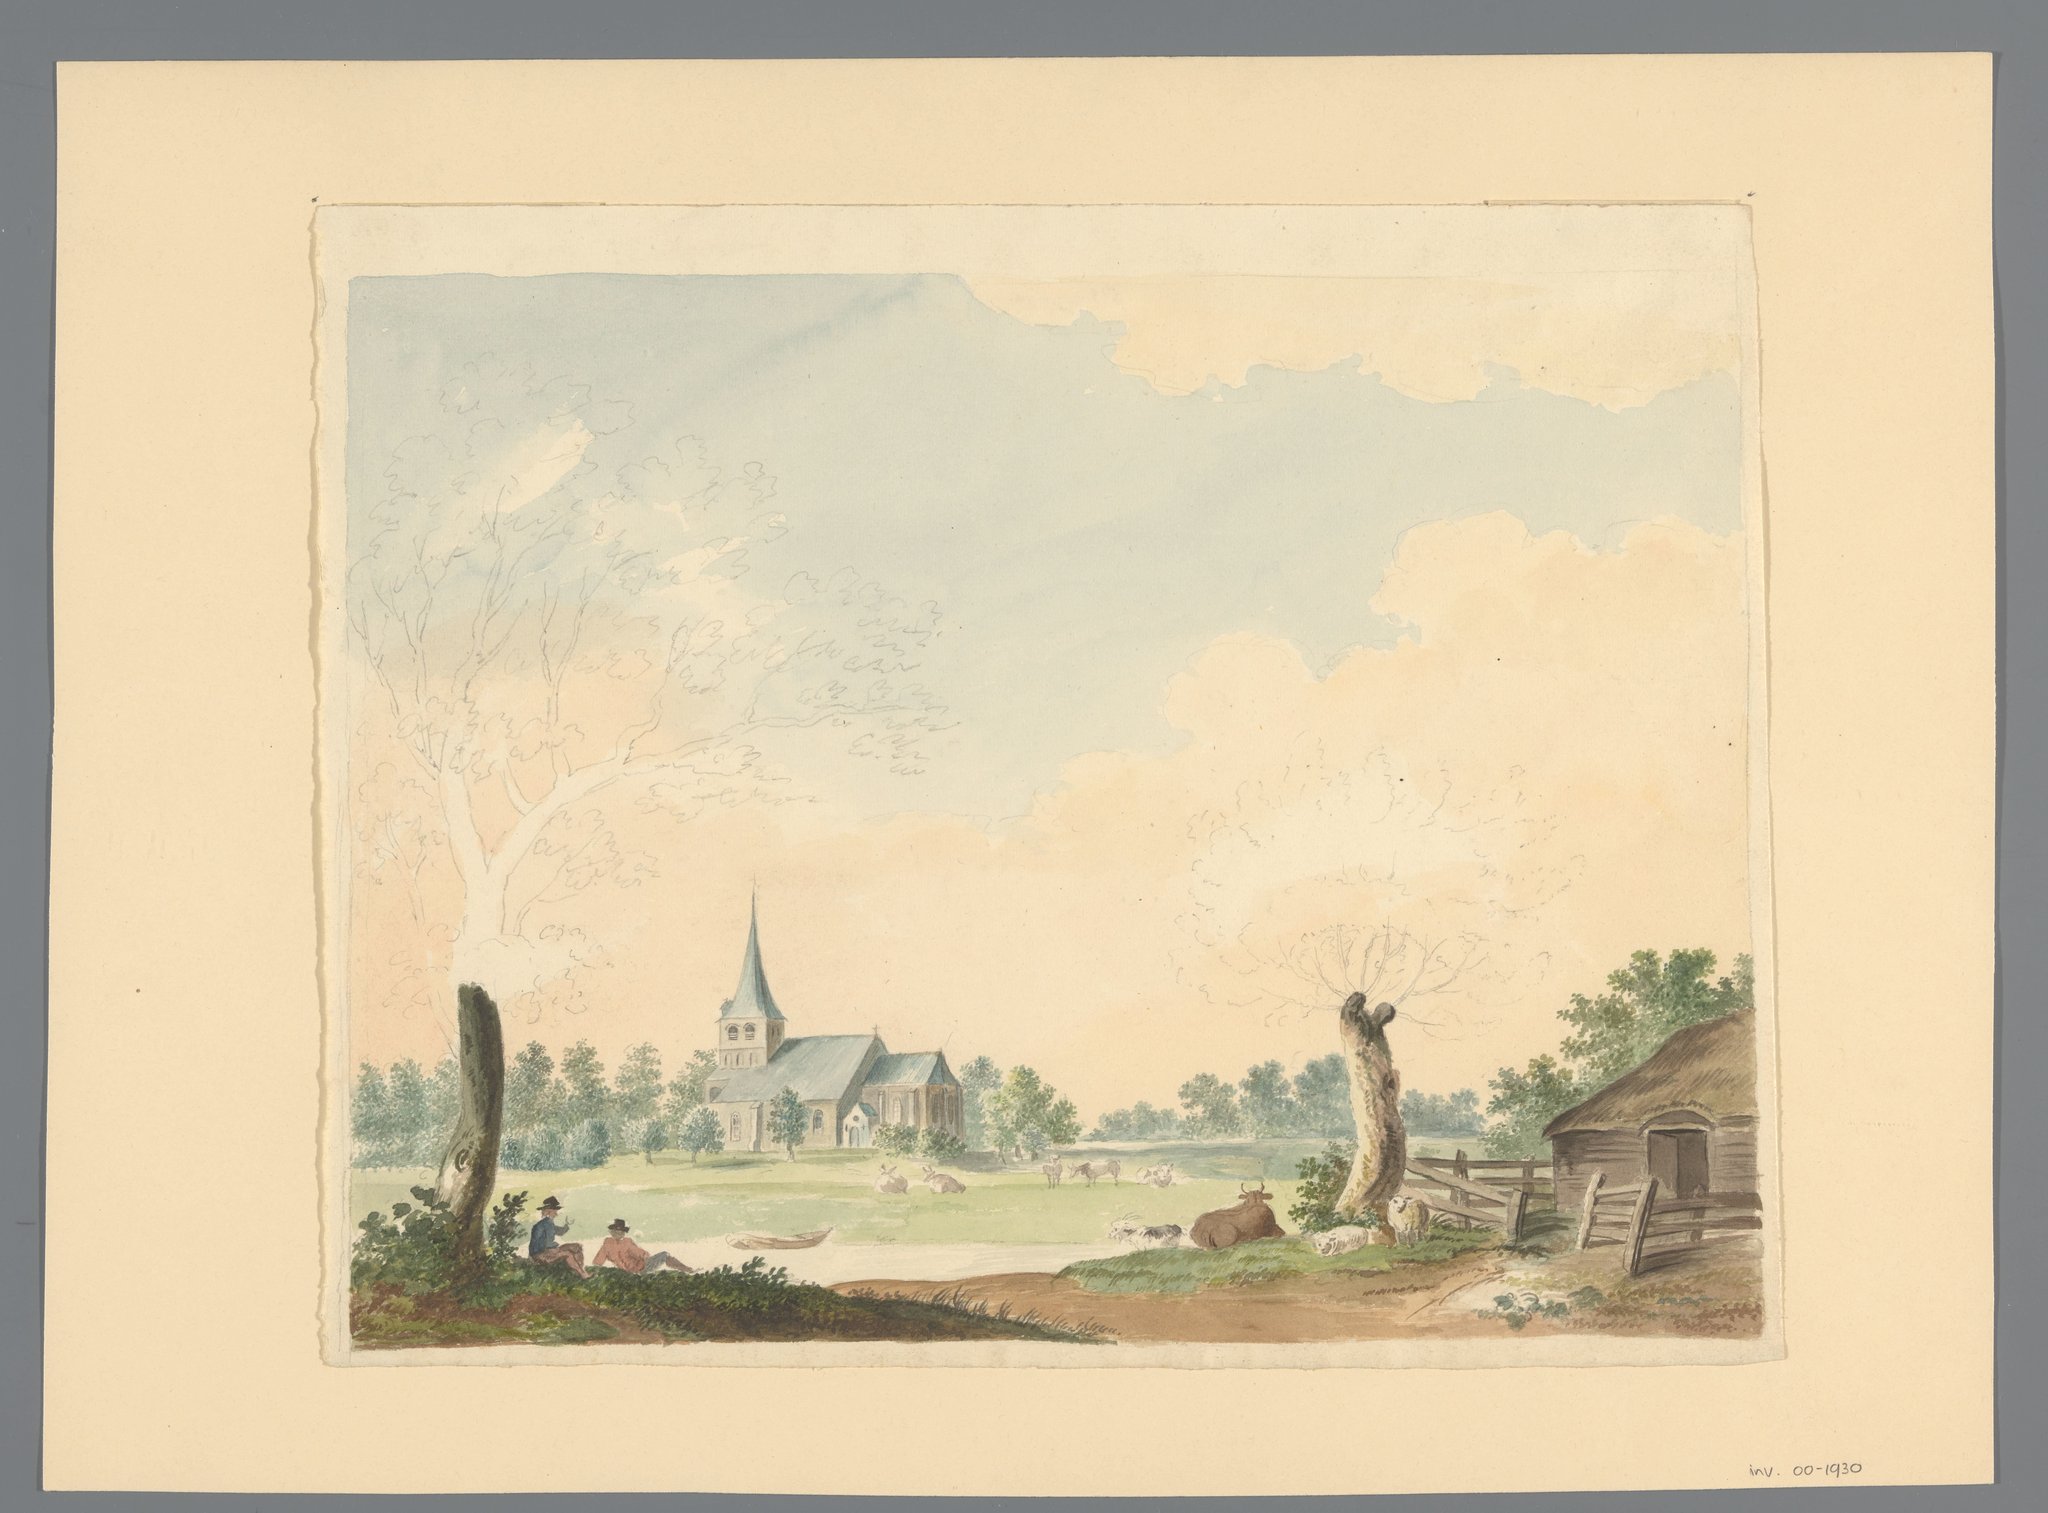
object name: drawing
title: Landschap met zicht over weiland op een kerk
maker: Anonymous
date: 1700-1800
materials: paper, pencil, watercolor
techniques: brush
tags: church (exterior)